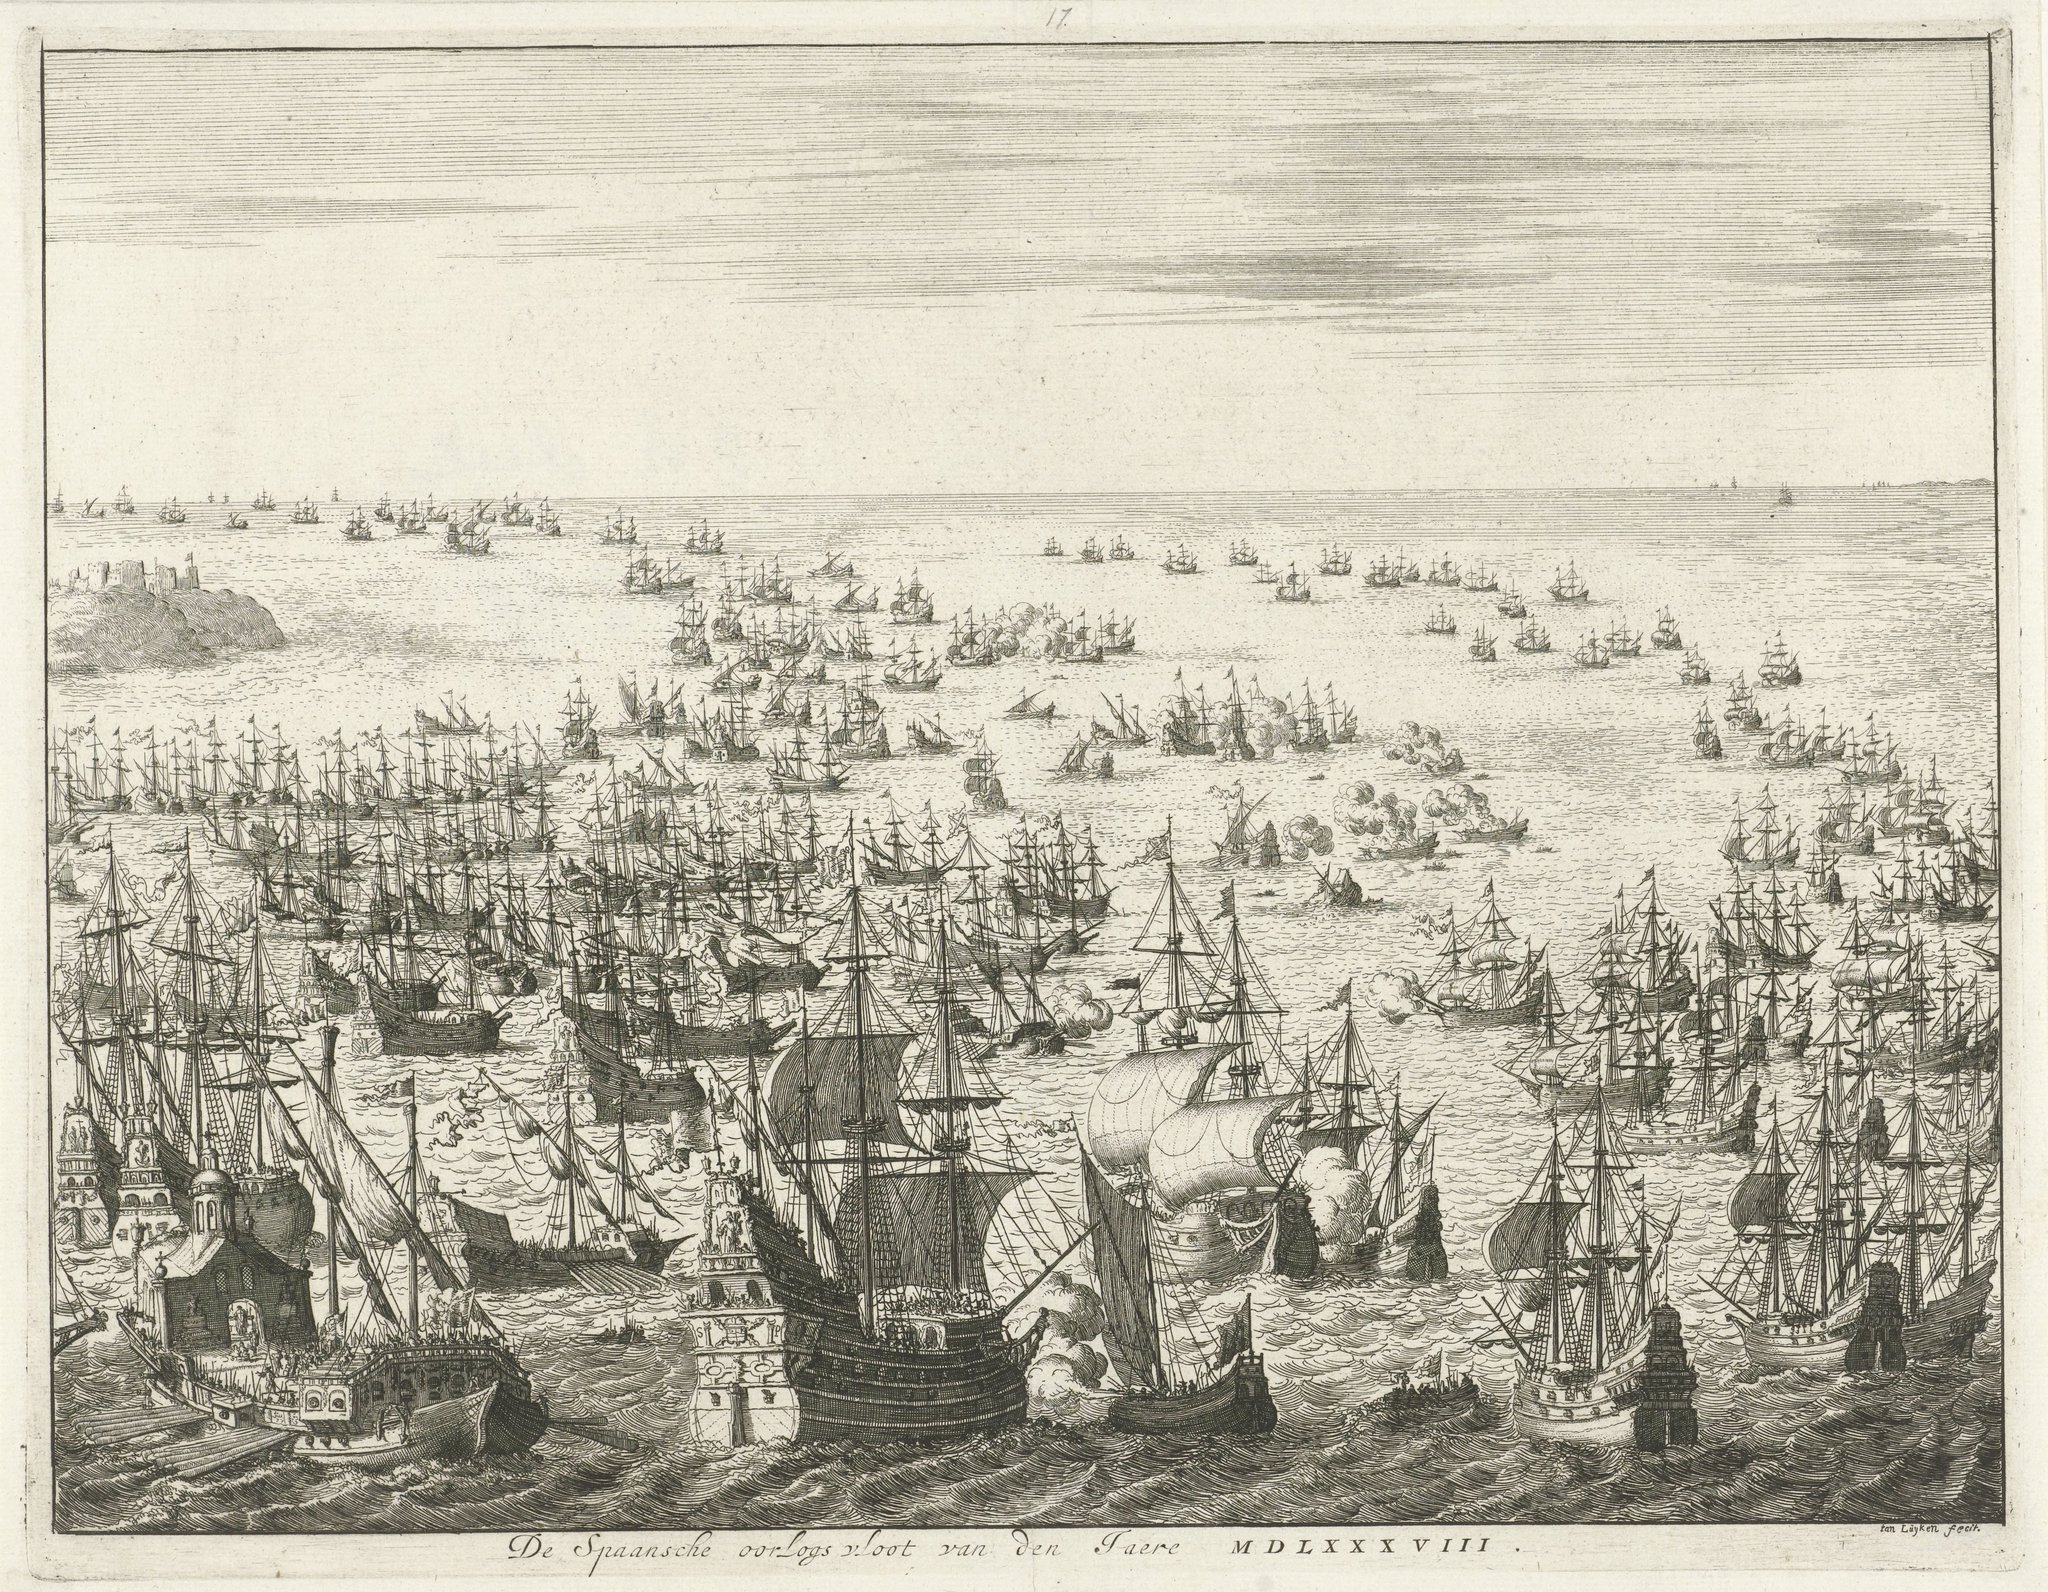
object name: print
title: De Spaansche oorlogsvloot van den Jaere MDLXXXVIII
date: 1679-1684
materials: paper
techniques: etching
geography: amsterdam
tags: battle (+ naval force), english channel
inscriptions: collector's mark: Lugt 2228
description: Ondergang van de Spaanse Armada of Onoverwinnelijke vloot, tussen 31 juli en 12 augustus 1588. Zeeslag tussen de Spaanse en gecombineerde Engelse en Nederlandse vloten in het Kanaal. Op de voorgrond wordt een groot Spaans fregat beschoten door een klein Hollands schip met het vaandel van de stad Leiden, links een galei.